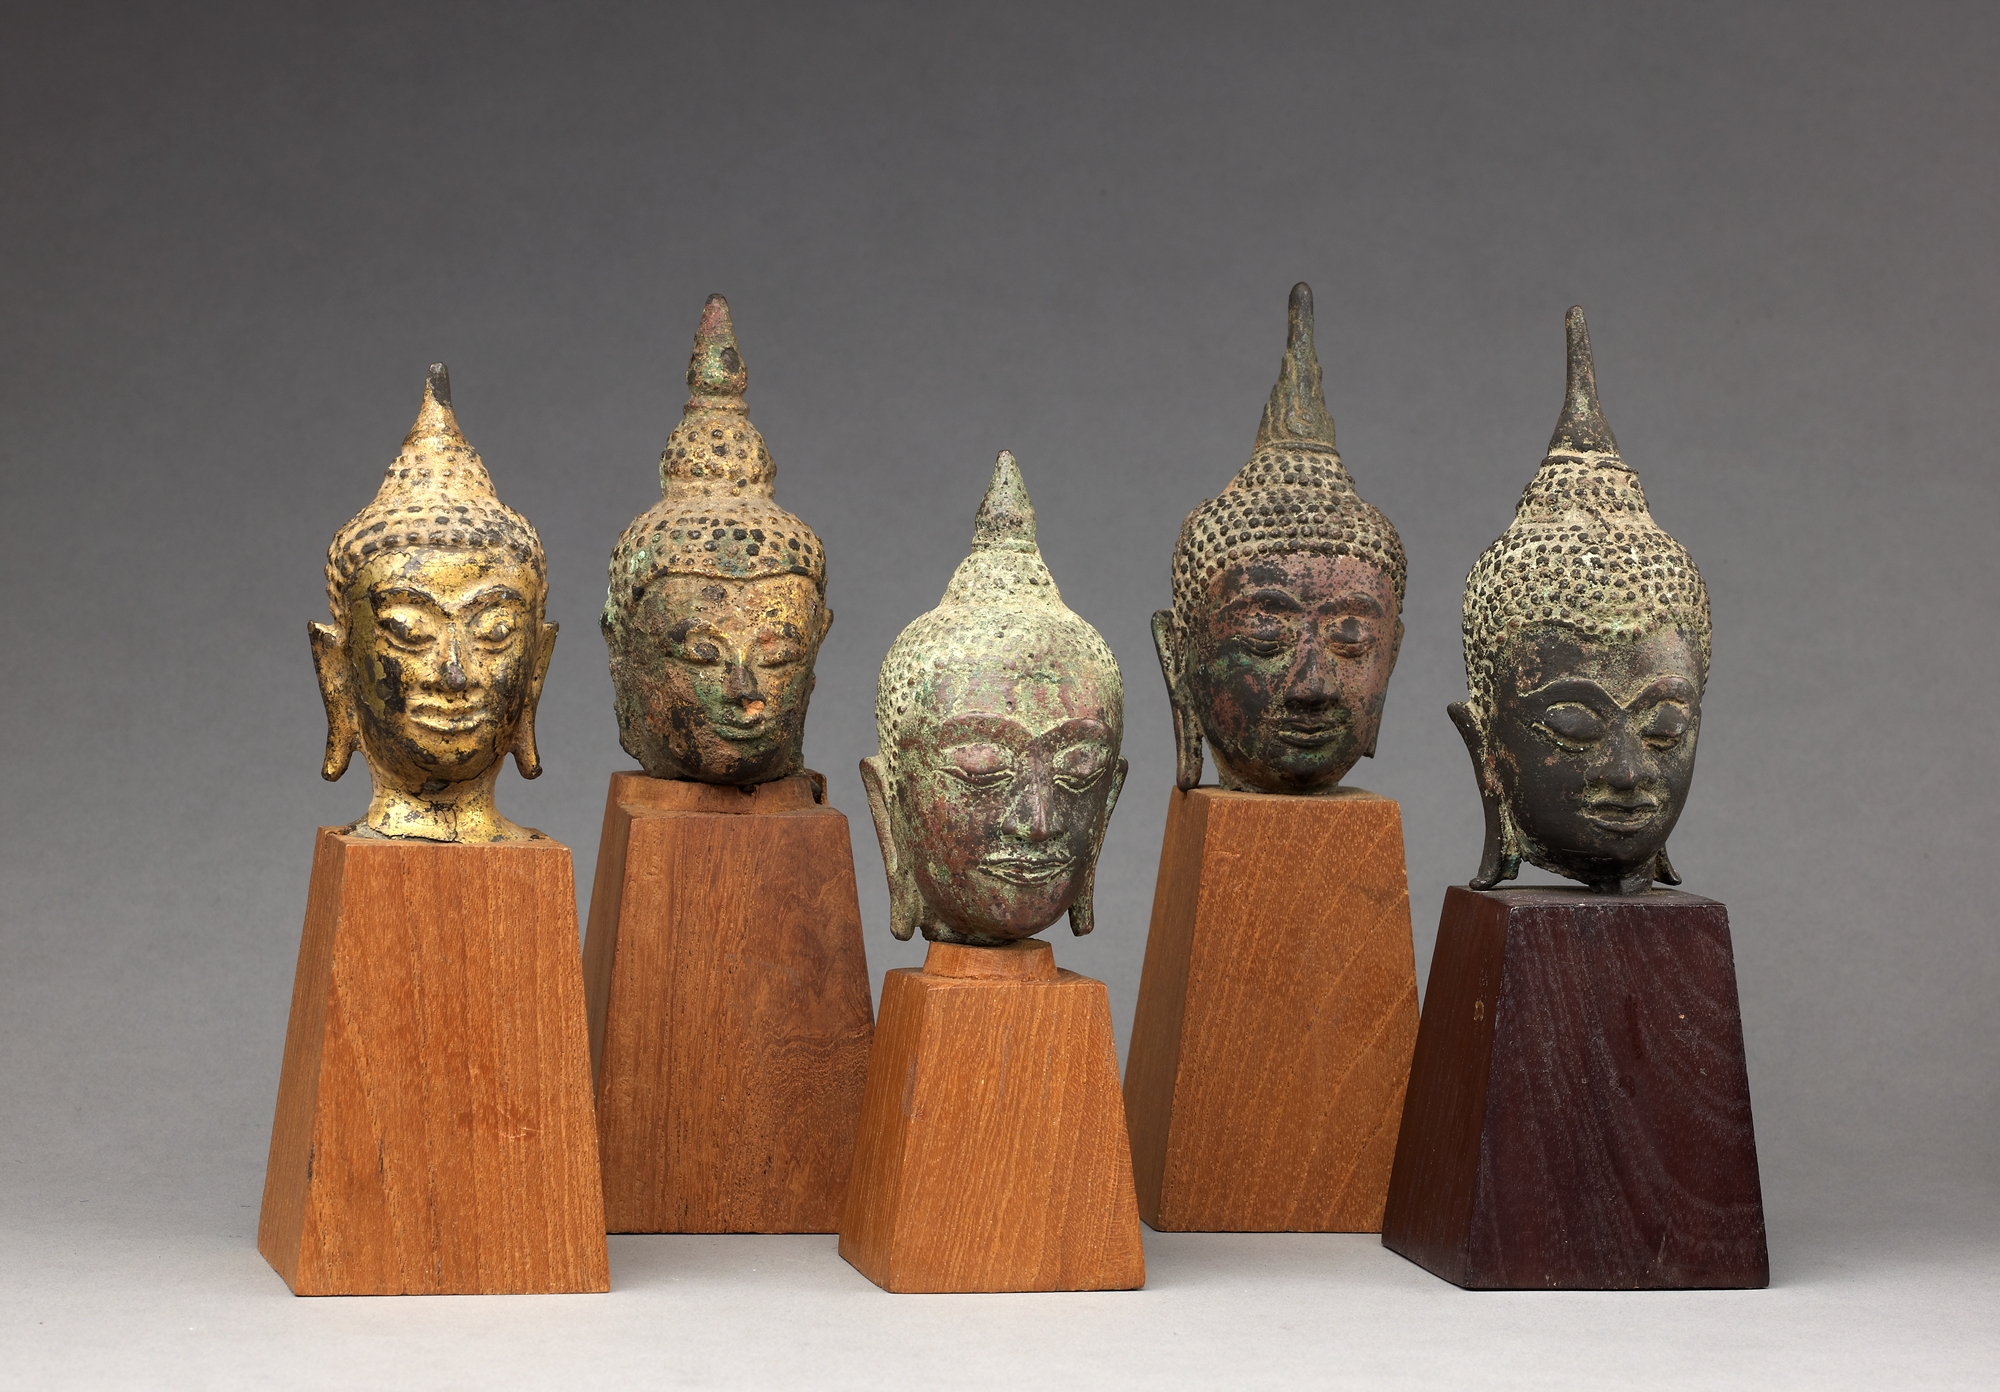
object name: sculpture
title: Head of the Buddha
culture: thai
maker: thai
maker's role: artist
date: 1767-1900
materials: copper alloy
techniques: gilding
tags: heads,buddha